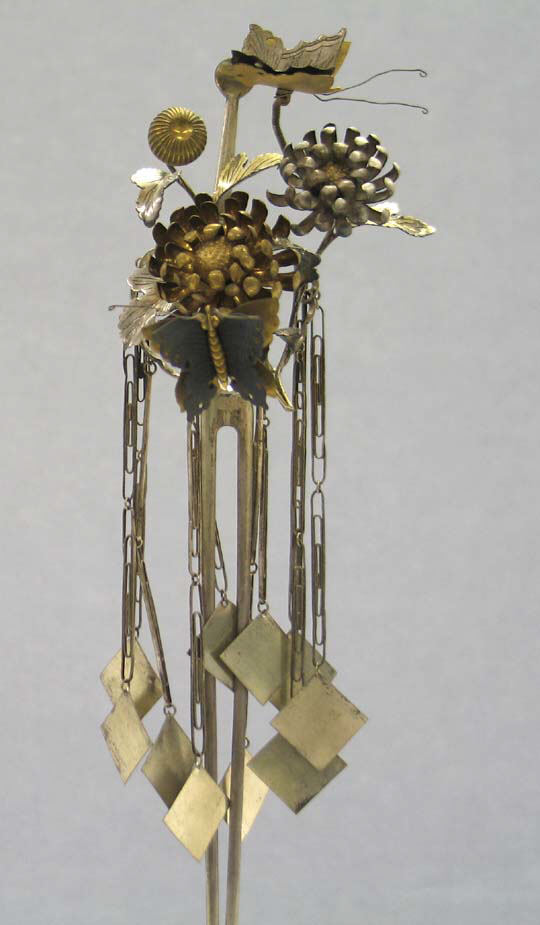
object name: hair ornament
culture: japanese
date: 1867-1900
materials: metal, silver, silver gilt